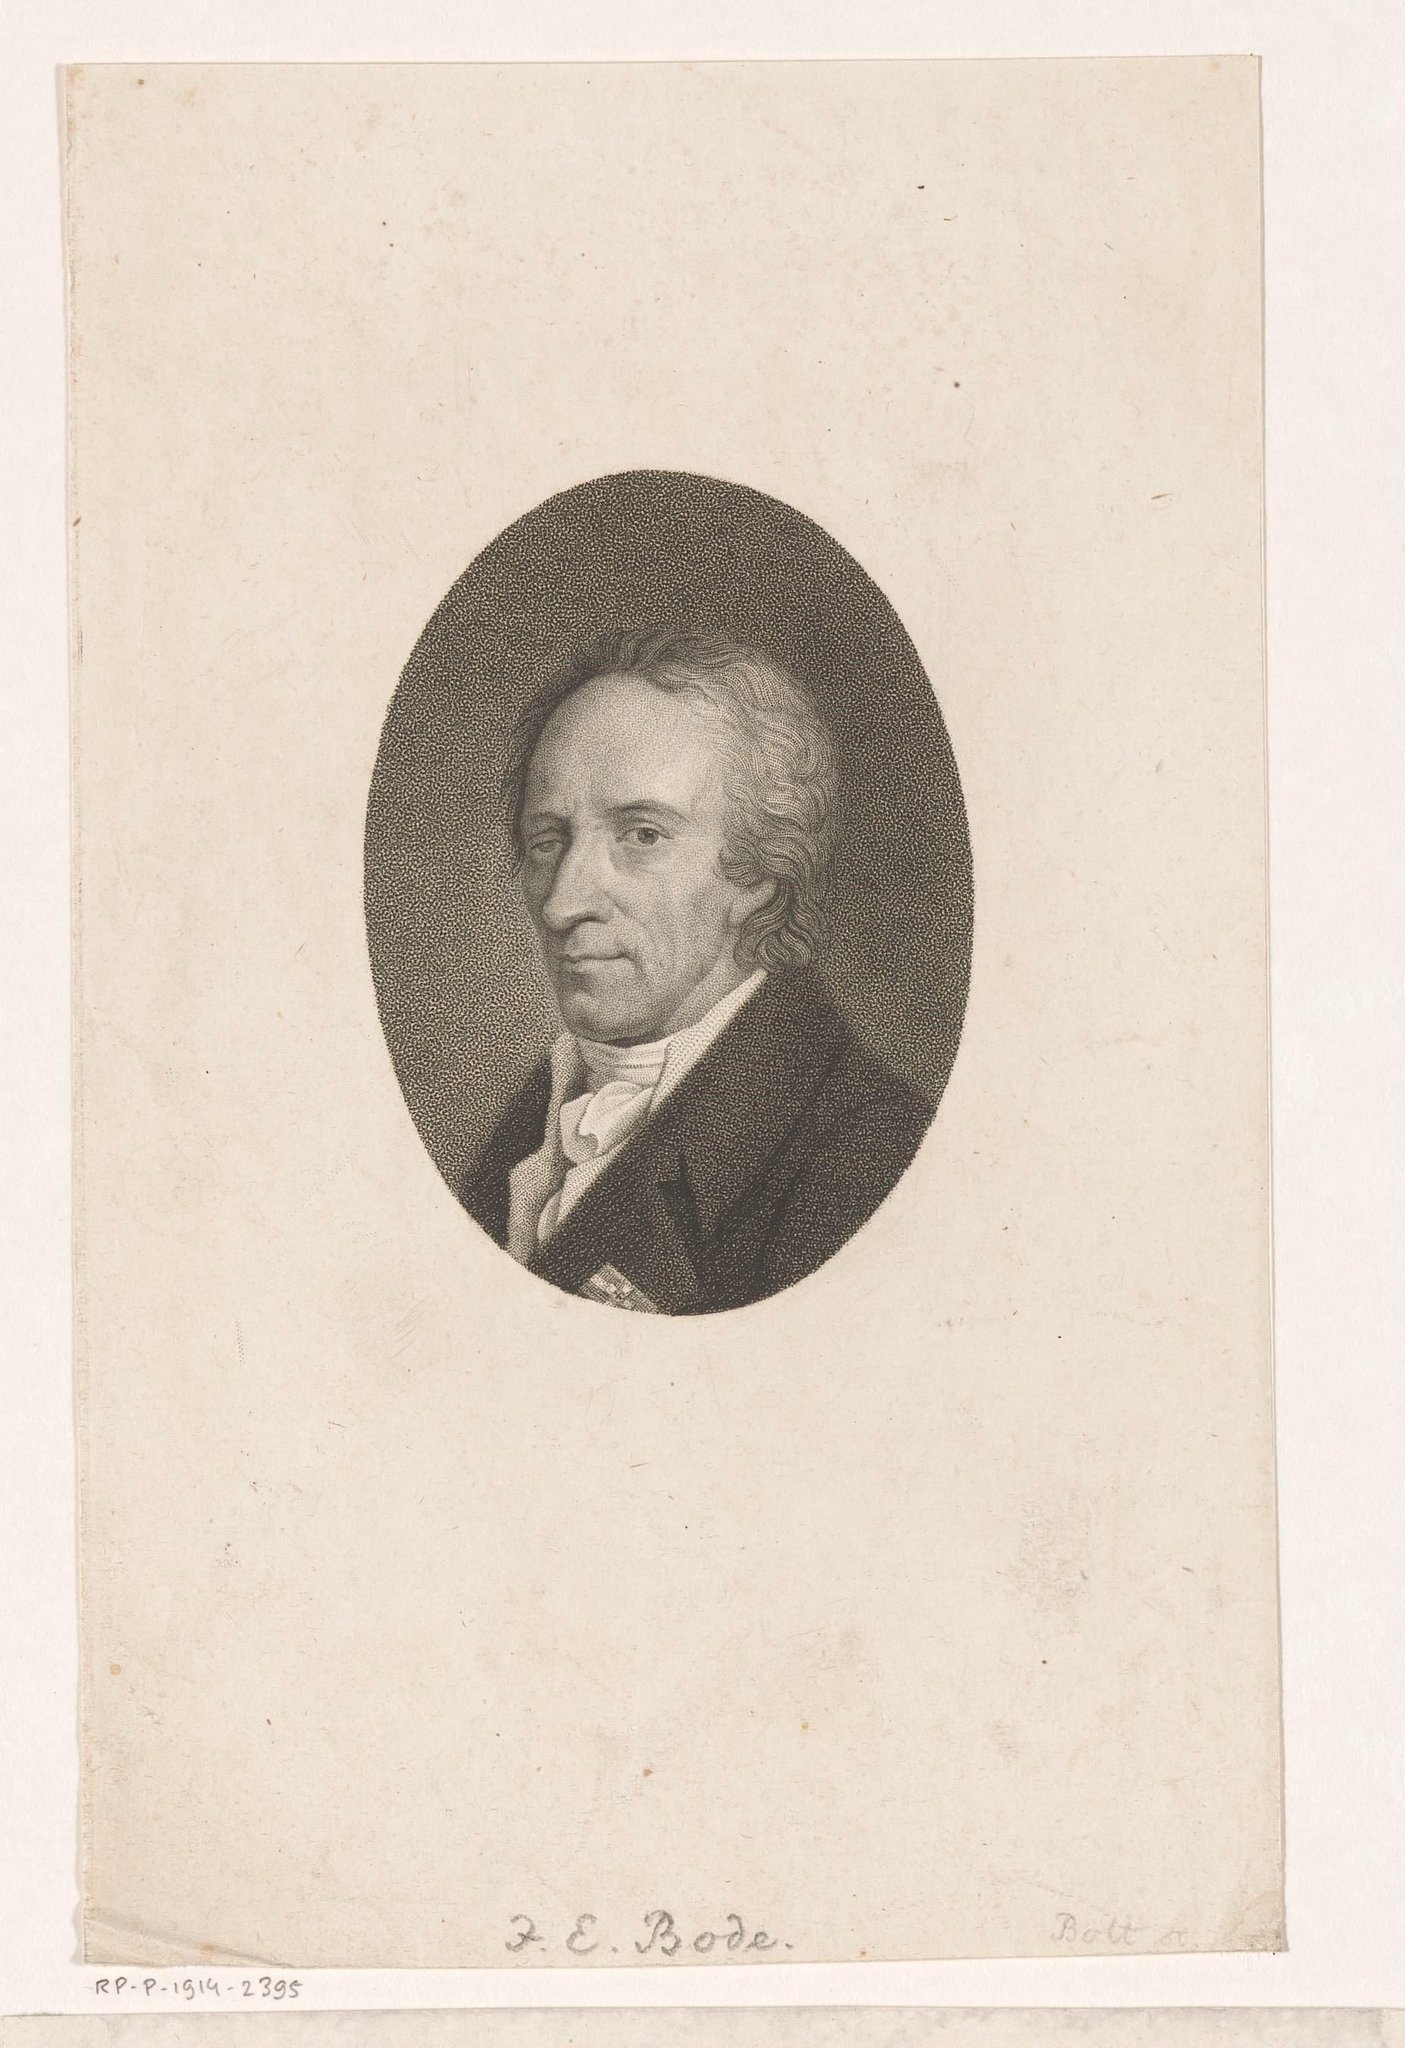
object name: print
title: Portret van Johann Elert Bode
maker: friedrich wilhelm bollinger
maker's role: print maker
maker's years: 1777-1825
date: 1787-1825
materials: paper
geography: berlin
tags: historical persons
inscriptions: collector's mark: Lugt 2228